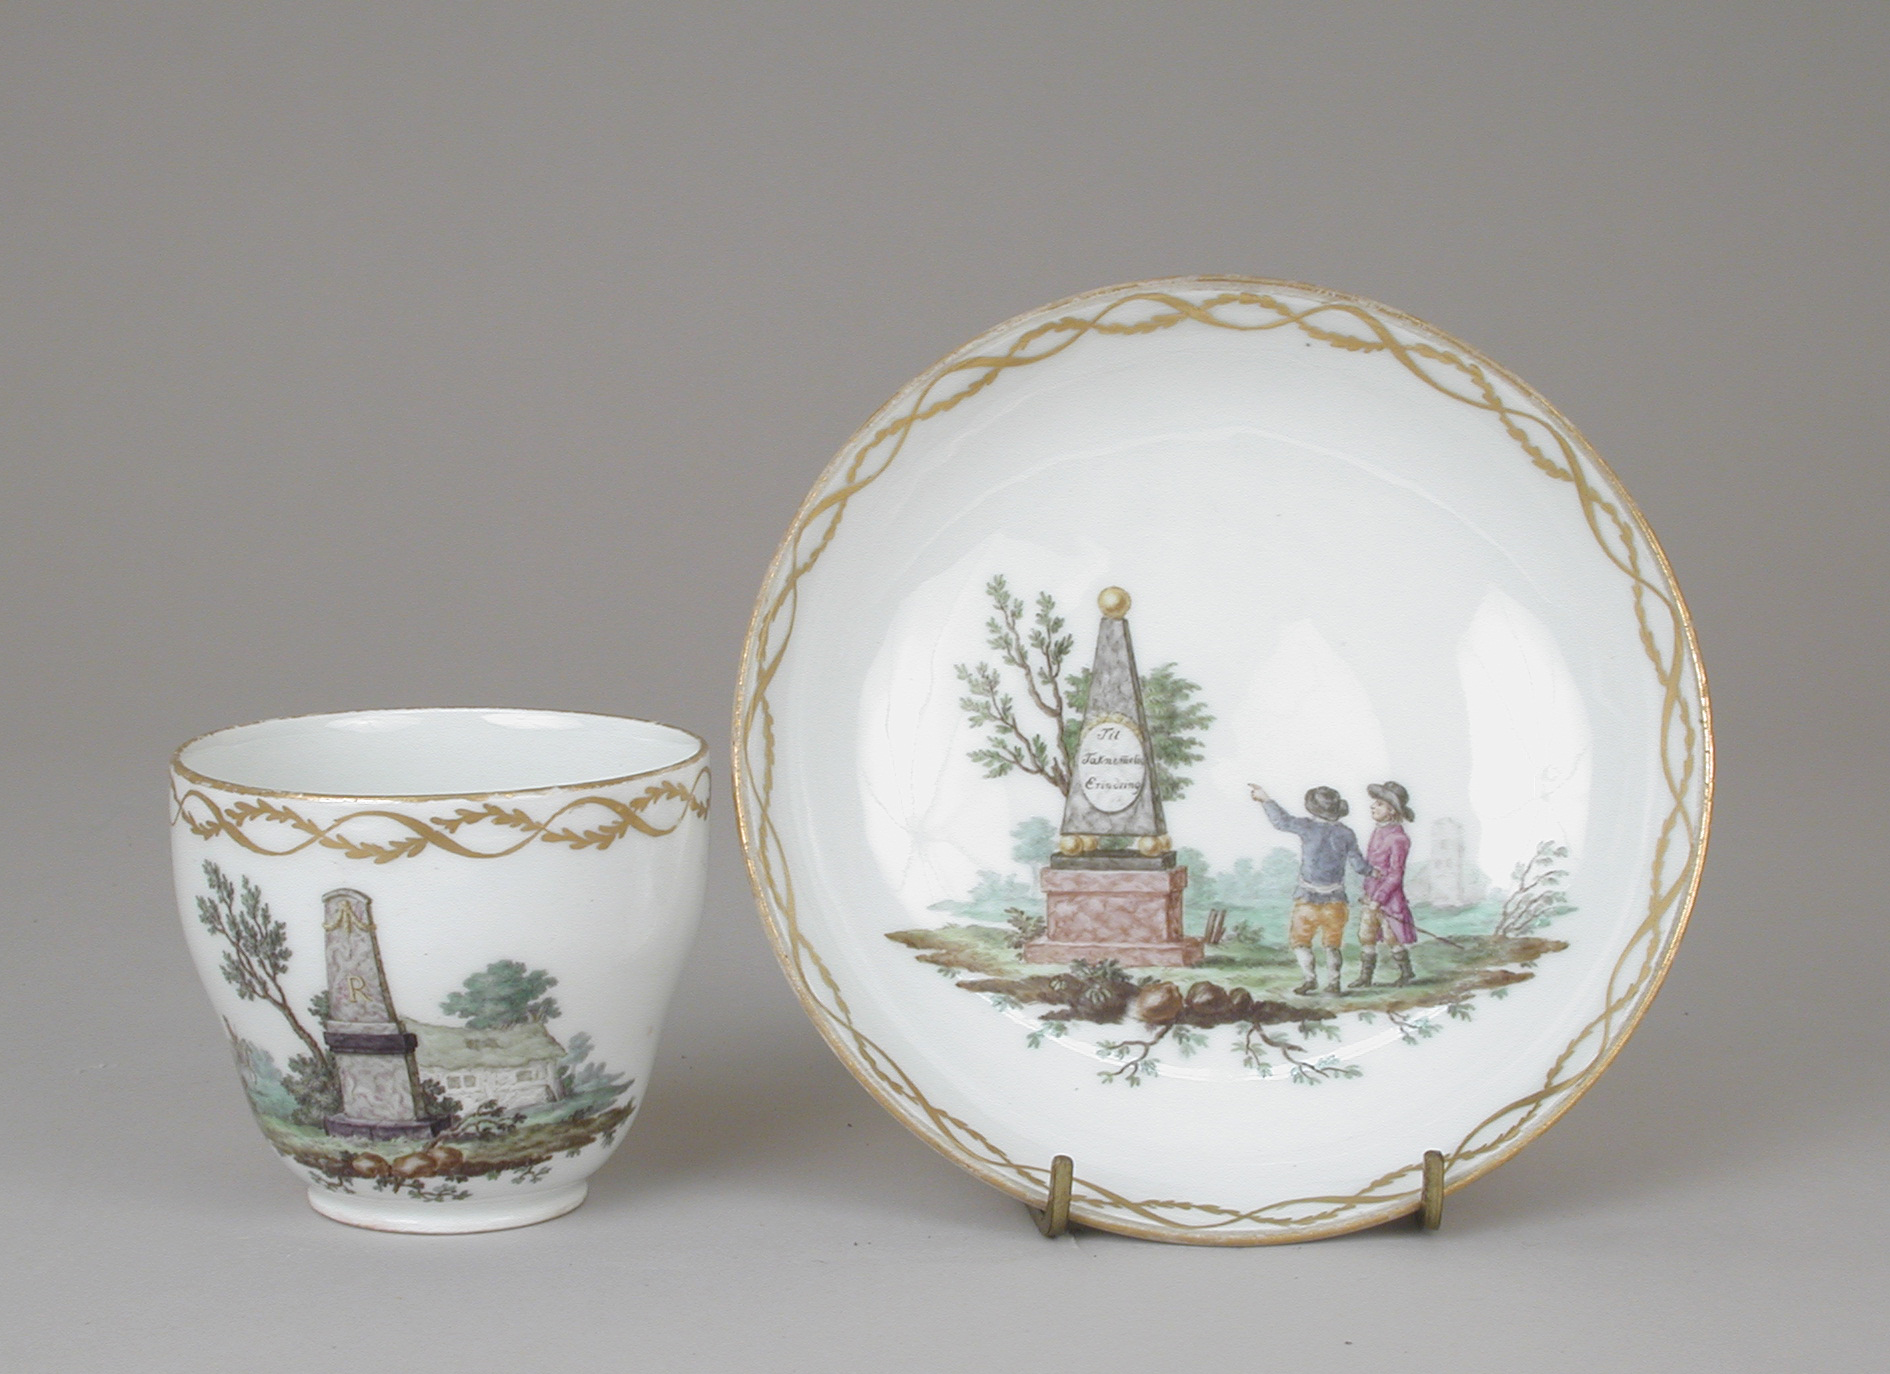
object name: cup and saucer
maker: royal porcelain manufactory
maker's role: factory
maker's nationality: danish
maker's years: 1775-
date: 1785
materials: hard paste porcelain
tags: monuments,men,trees